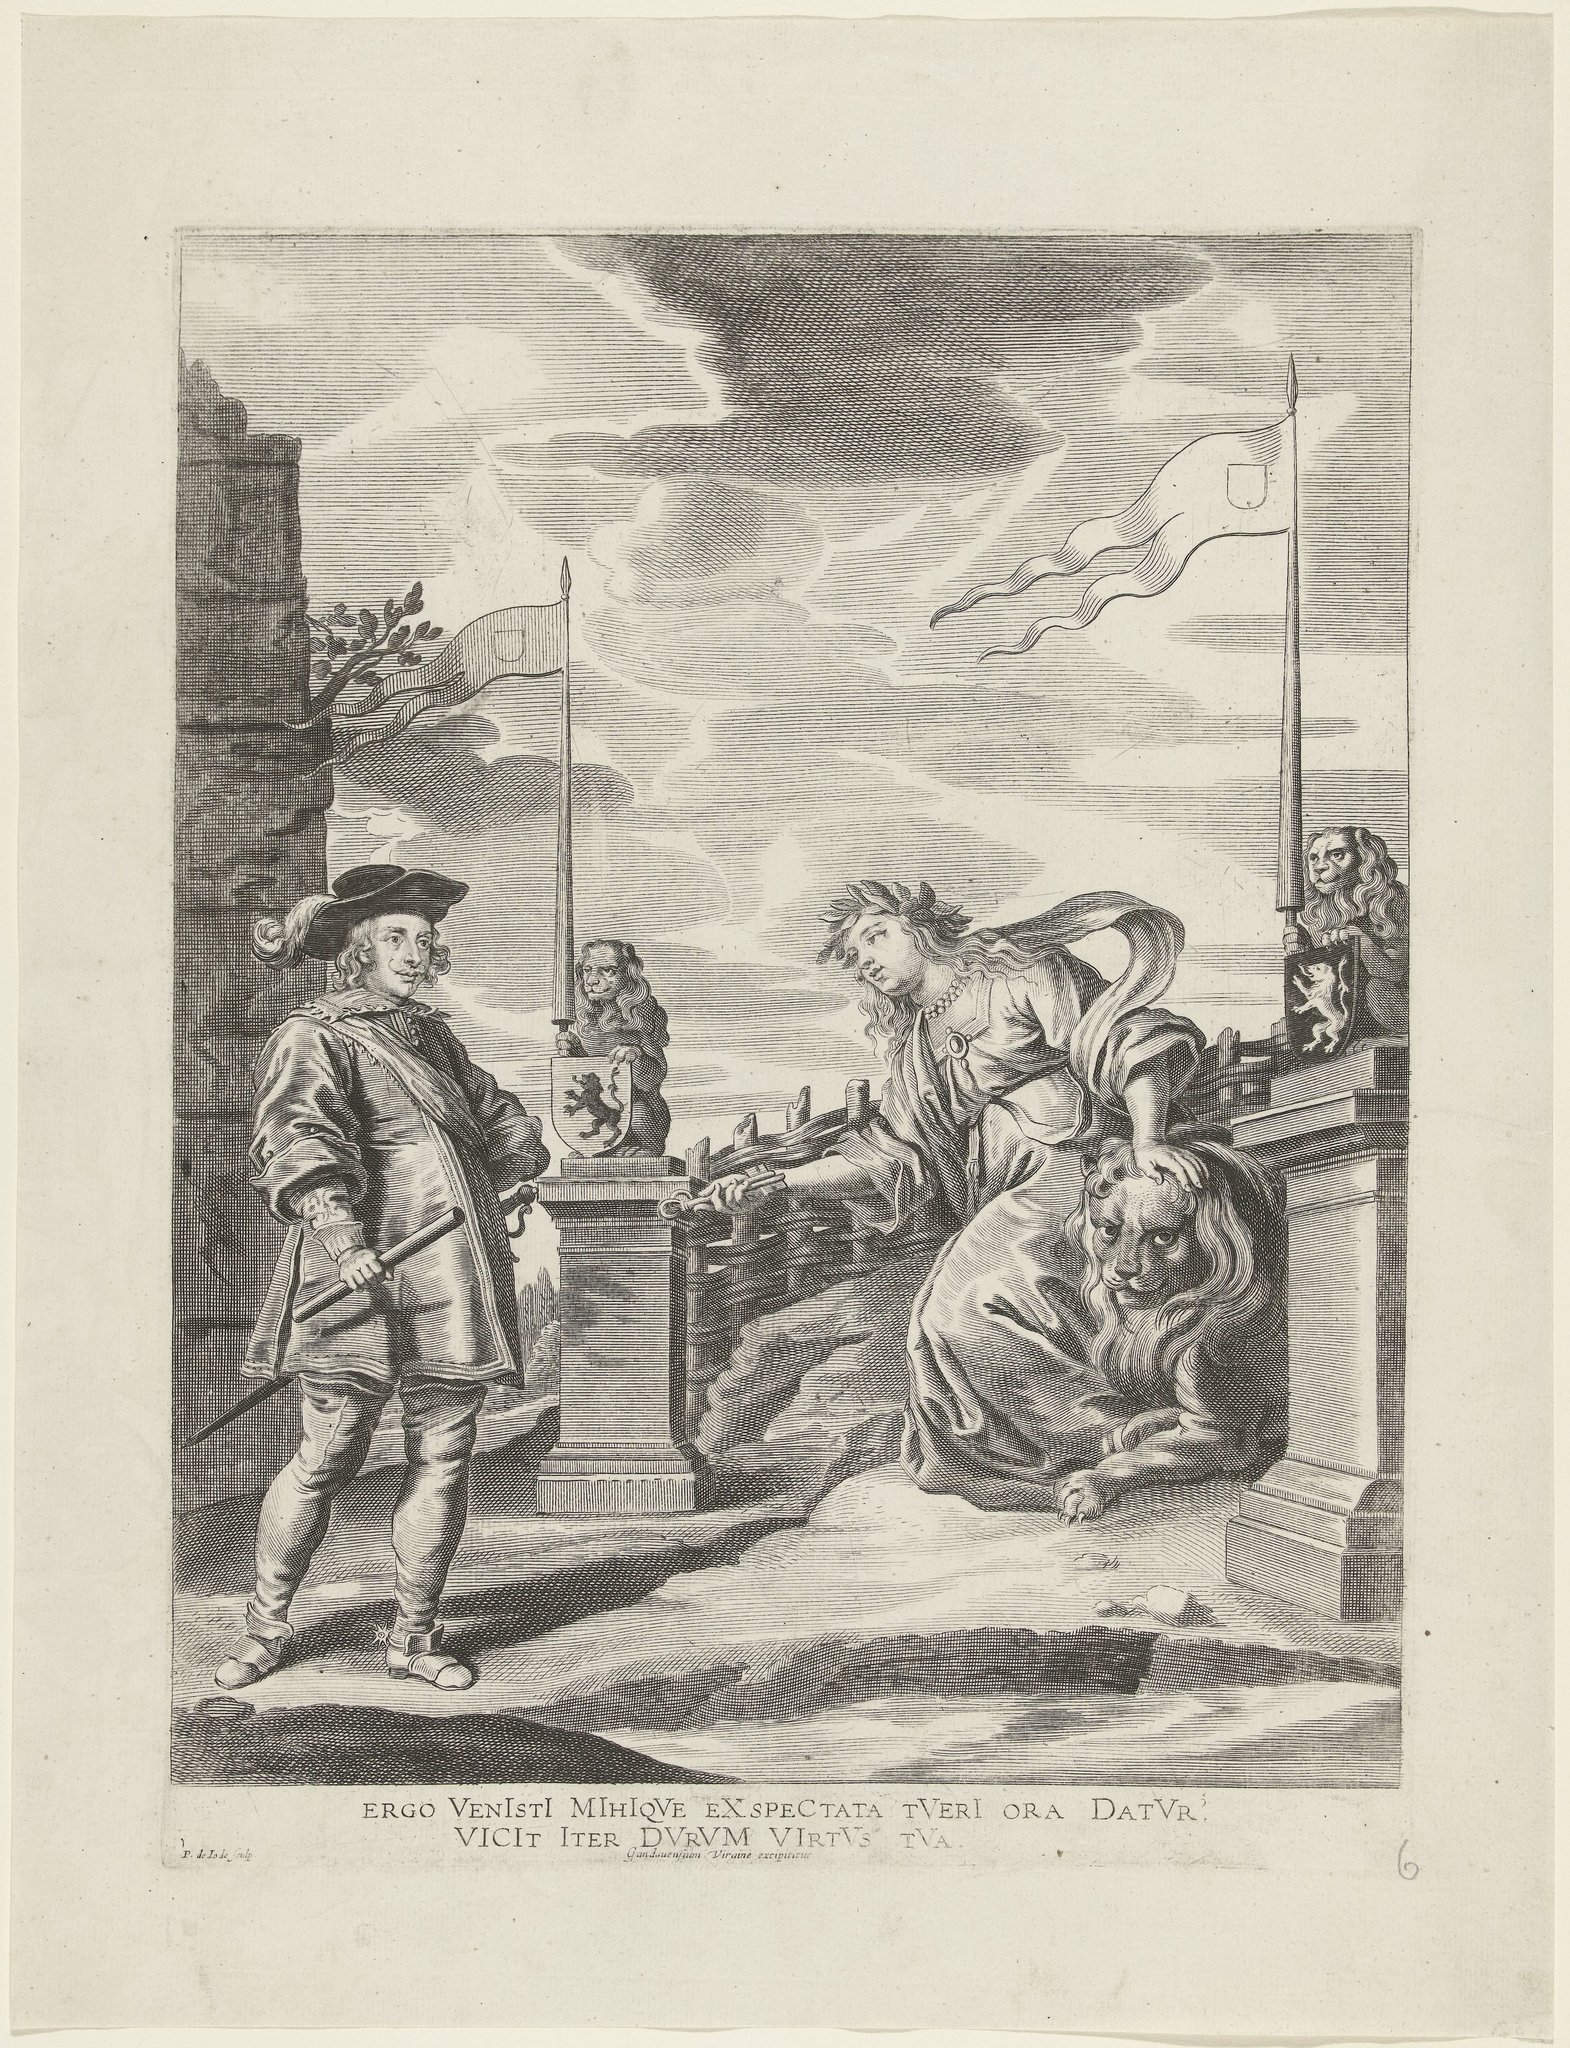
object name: print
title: Ferdinand ontvangt van de stedenmaagd van Gent de sleutels van de stad; intocht van Ferdinand te Gent in 1635 (nr. 6)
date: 1635-1636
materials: paper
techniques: engraving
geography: southern netherlands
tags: brussels, landvoogd der zuidelijke nederlanden ferdinand van oostenrijk, personification of a city, town-patron(ess), fenced or walled garden; 'hortus conclusus', triumphal entry and public reception, pageant, 'entrée solennelle', 'joyeuse entrée', ghent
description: Ferdinand ontvangt van de stedenmaagd van Gent gezeten bij de opening in een omheinde tuin de sleutels van de stad. Voorstelling centraal boven op de voorzijde van de triomfpoort Arcus Fernandi op de Vrijdagmarkt. Blad nr. 6 in een geheel van 42 platen die de uitgave van de beschrijving van de intocht van de Kardinaal Infant Ferdinand van Oostenrijk te Gent op 28 januari 1635 als de nieuwe landvoogd voor de Spaanse Nederlanden illustreren.